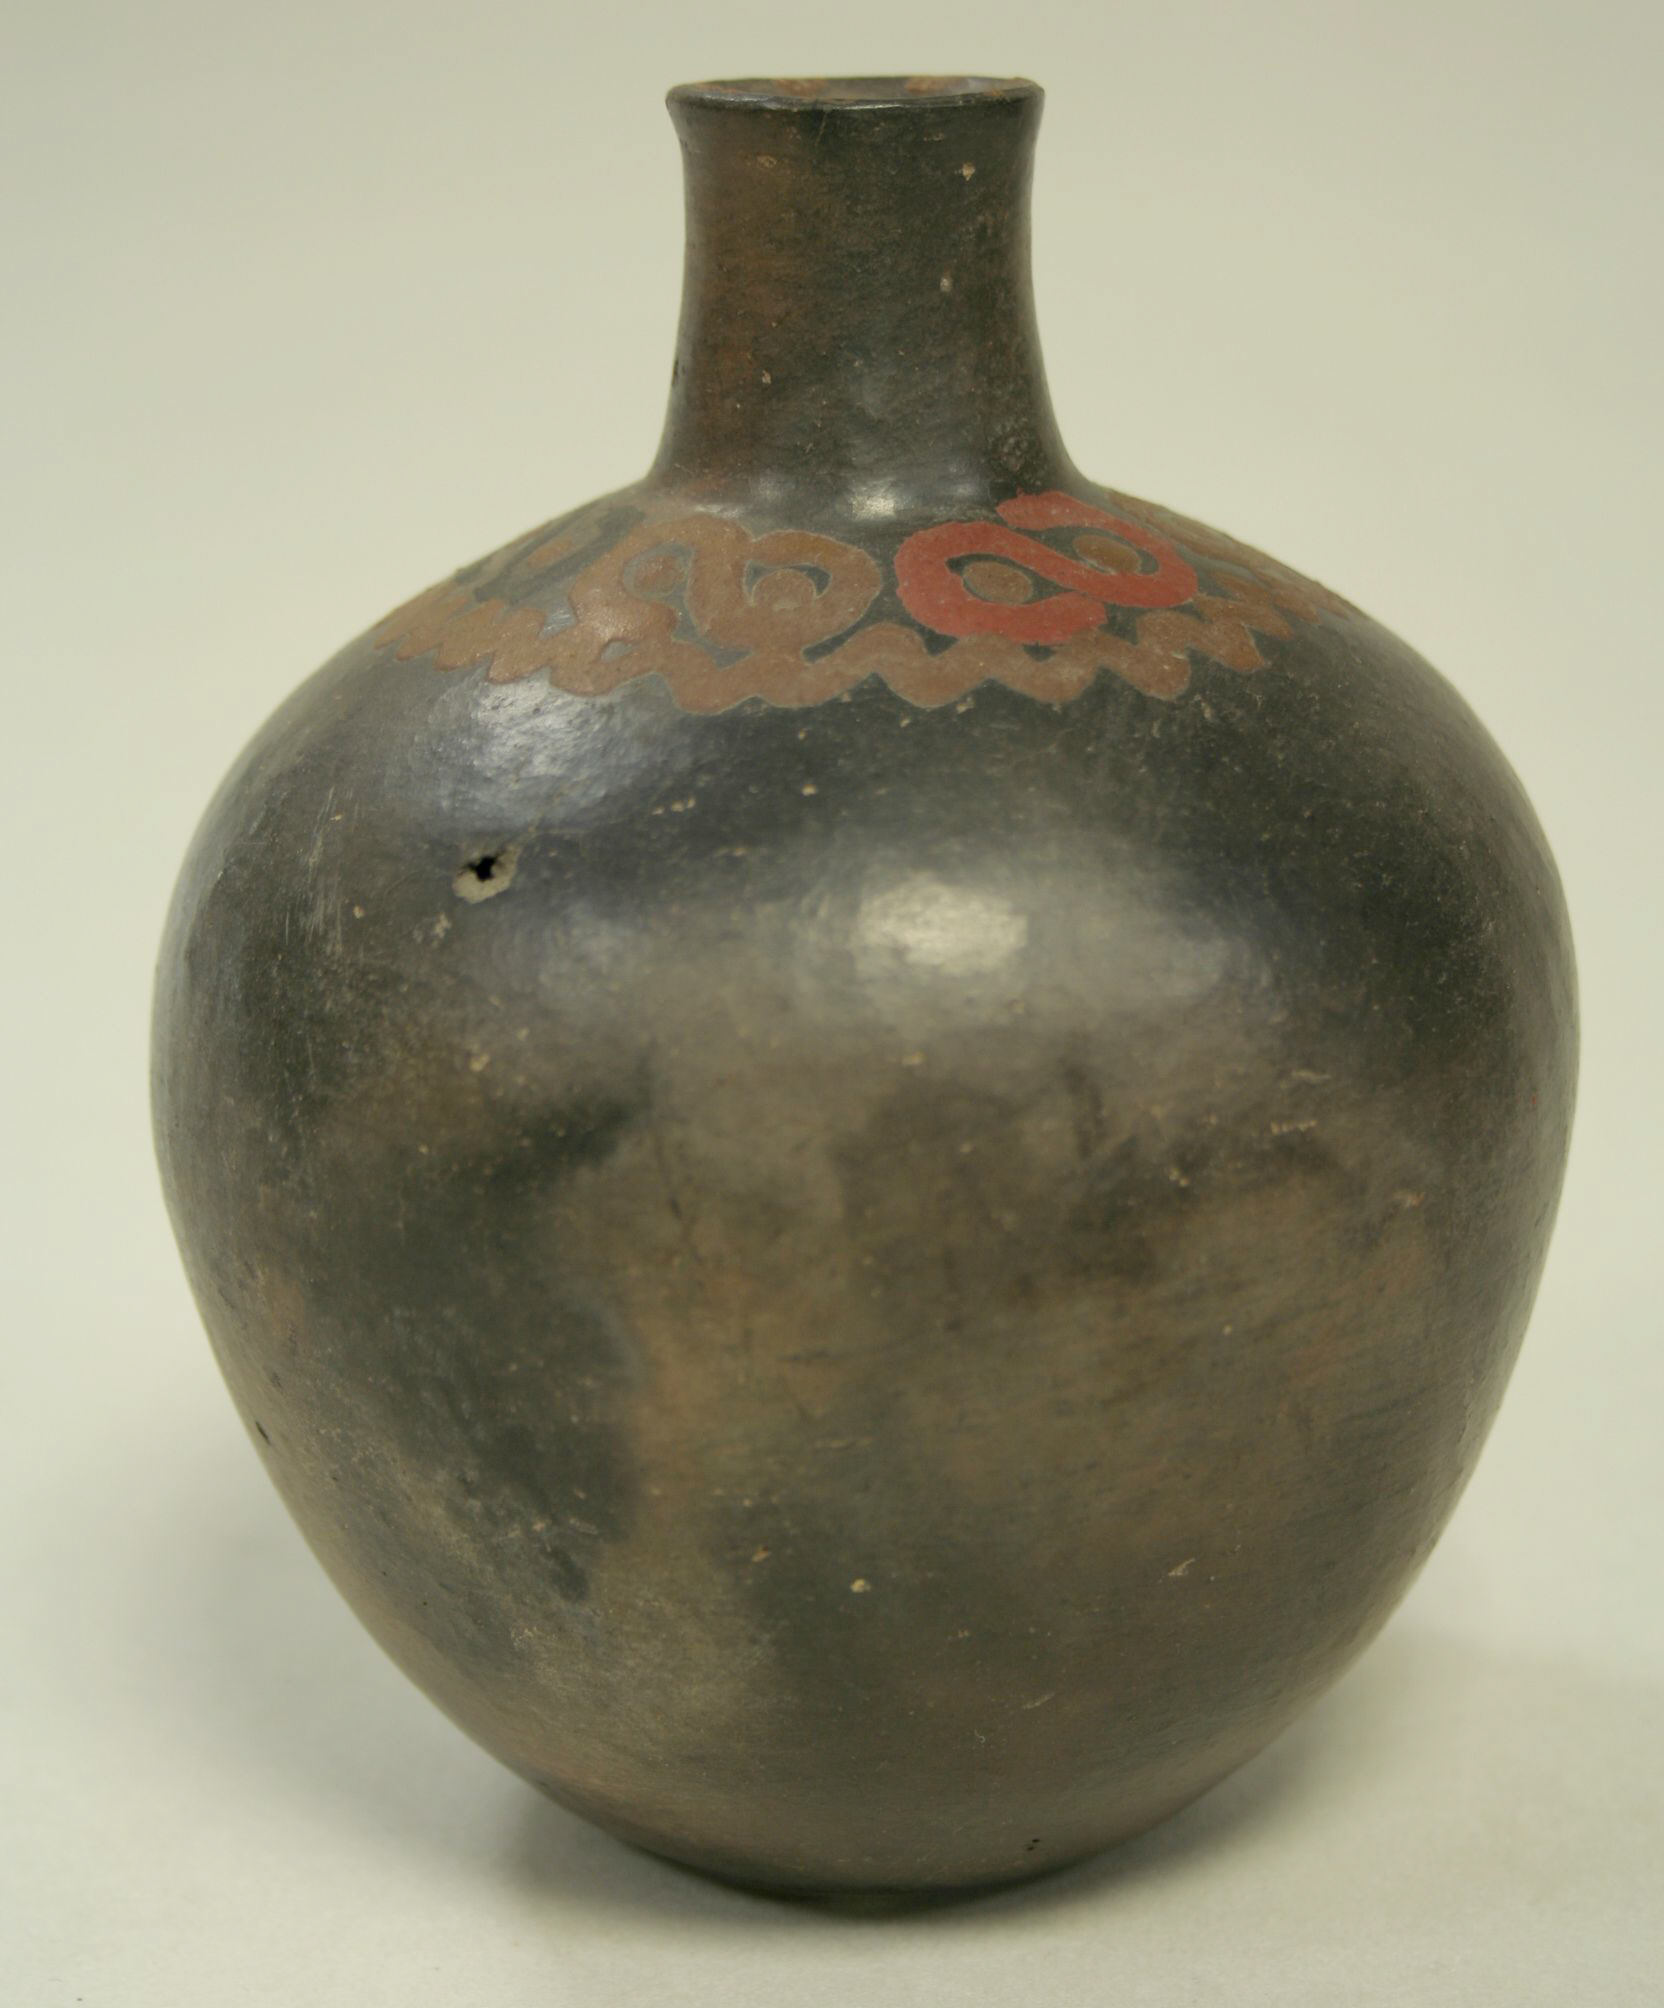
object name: bottle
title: Single Spout Painted Bottle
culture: paracas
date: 500-101 BCE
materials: ceramic, pigment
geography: peru